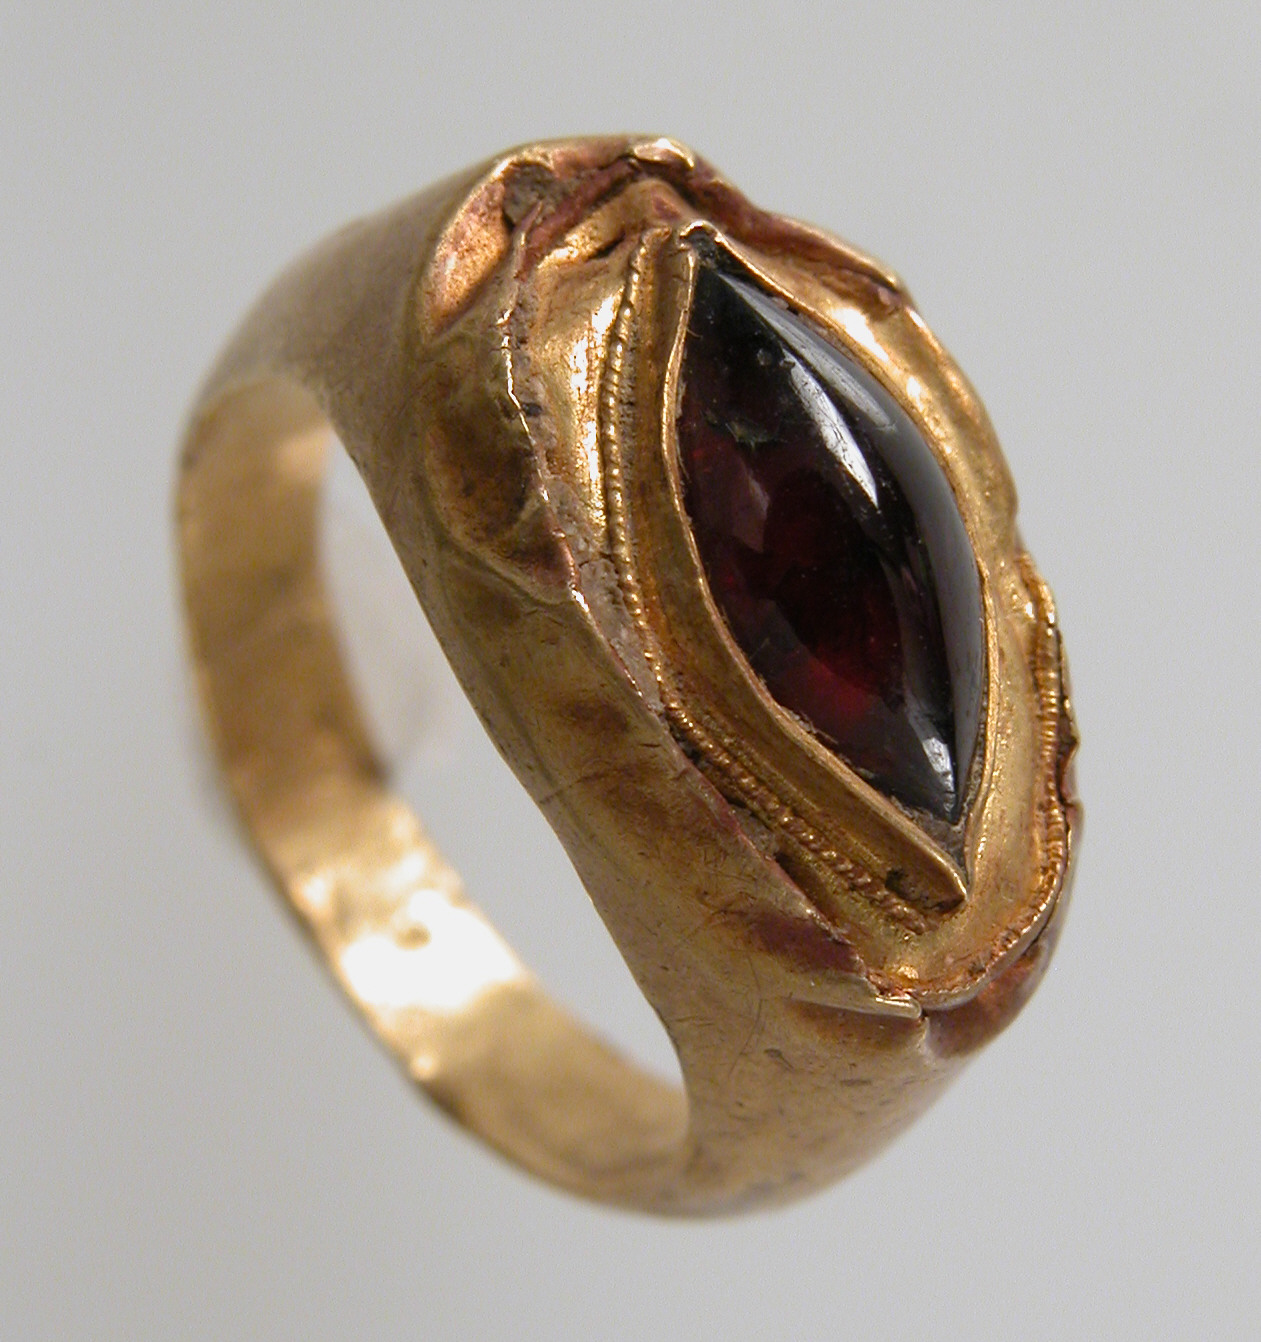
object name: ring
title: Finger Ring with Oval Bezel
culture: frankish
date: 601-700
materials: gemstone, gold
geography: northern france